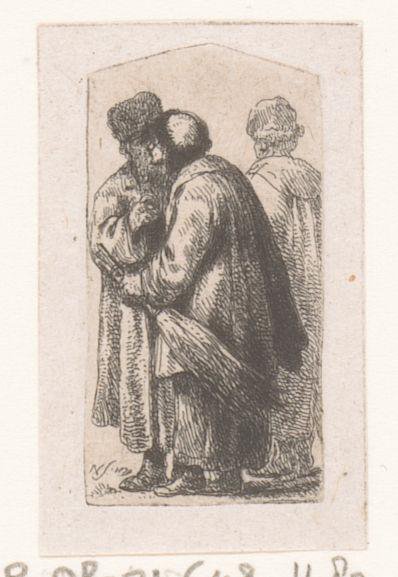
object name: print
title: Drie mannen waarvan één met korte bezem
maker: jean pierre norblin de la gourdaine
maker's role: print maker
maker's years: 1745-1830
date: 1779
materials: paper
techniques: etching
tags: head-gear (with name), street sweeping, street sweeper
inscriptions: date